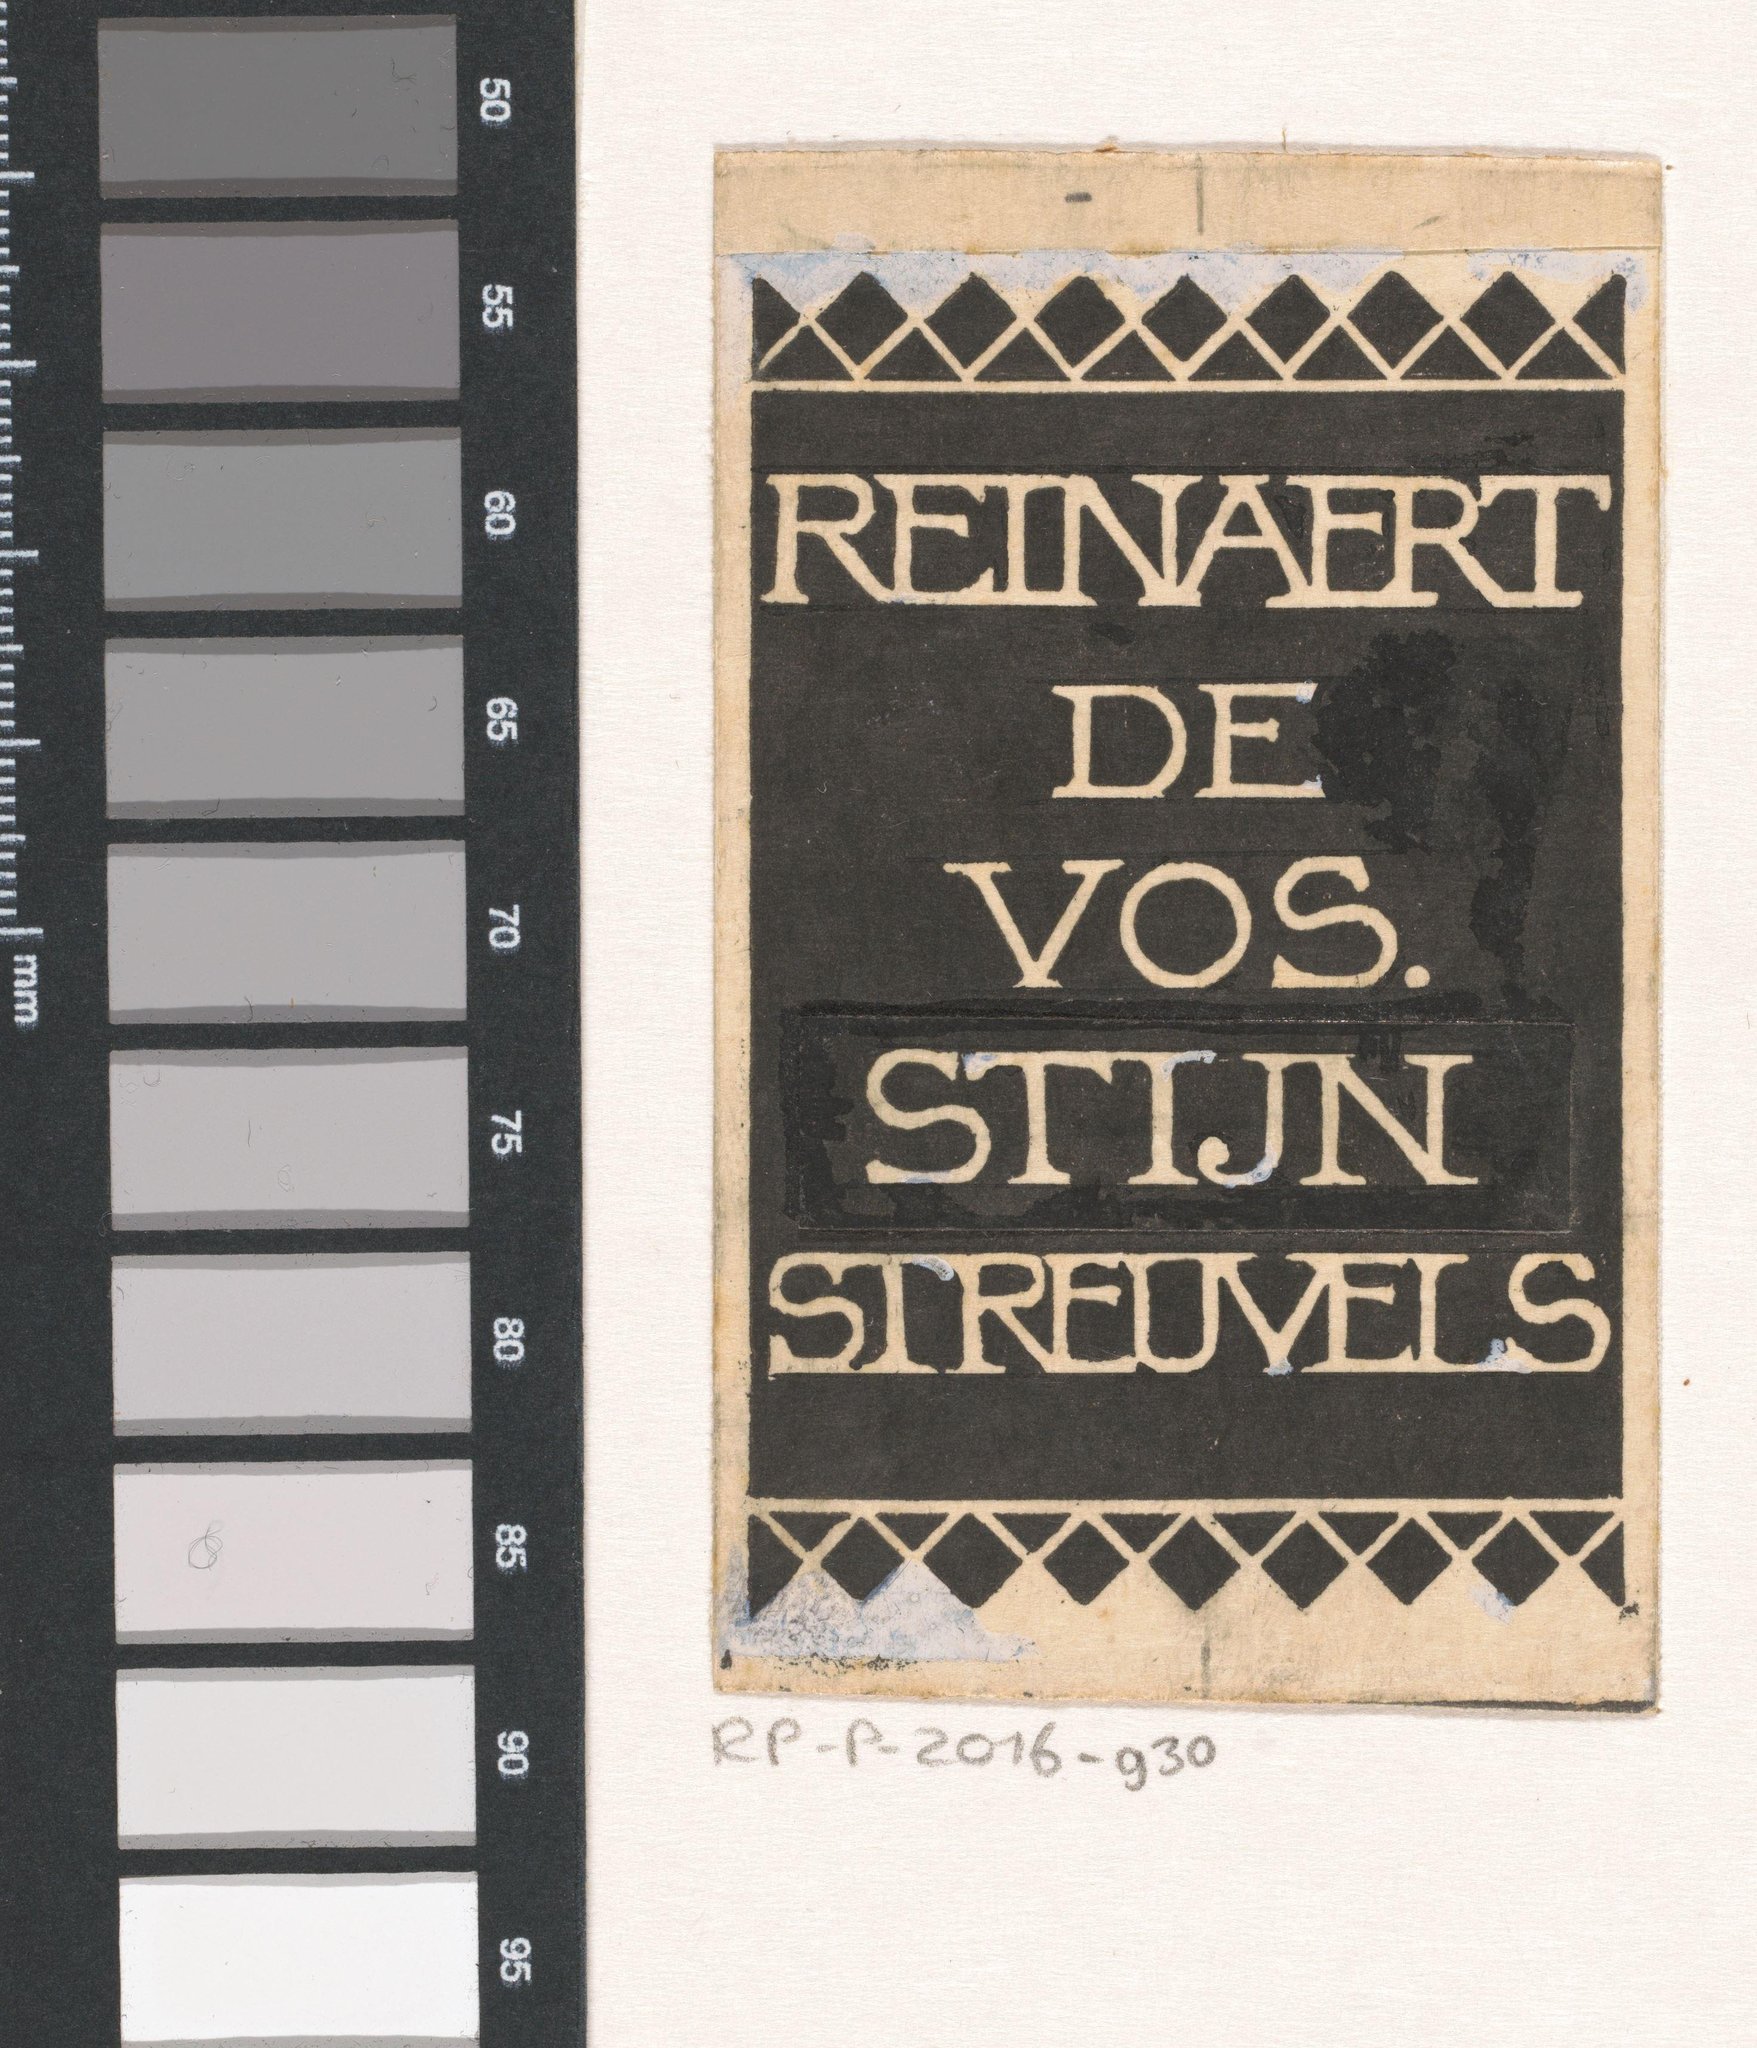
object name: boekrug ontwerp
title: Ontwerp voor een boekrug voor: Stijn Streuvels, Reinaert de Vos, 1910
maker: Anonymous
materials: paint, ink, paper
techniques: brush, printing block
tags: ornament ~ geometric motifs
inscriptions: collector's mark: Lugt 2228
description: Ontwerp voor een boekrug met boven en onder de boektitel een patroon met driehoeken.